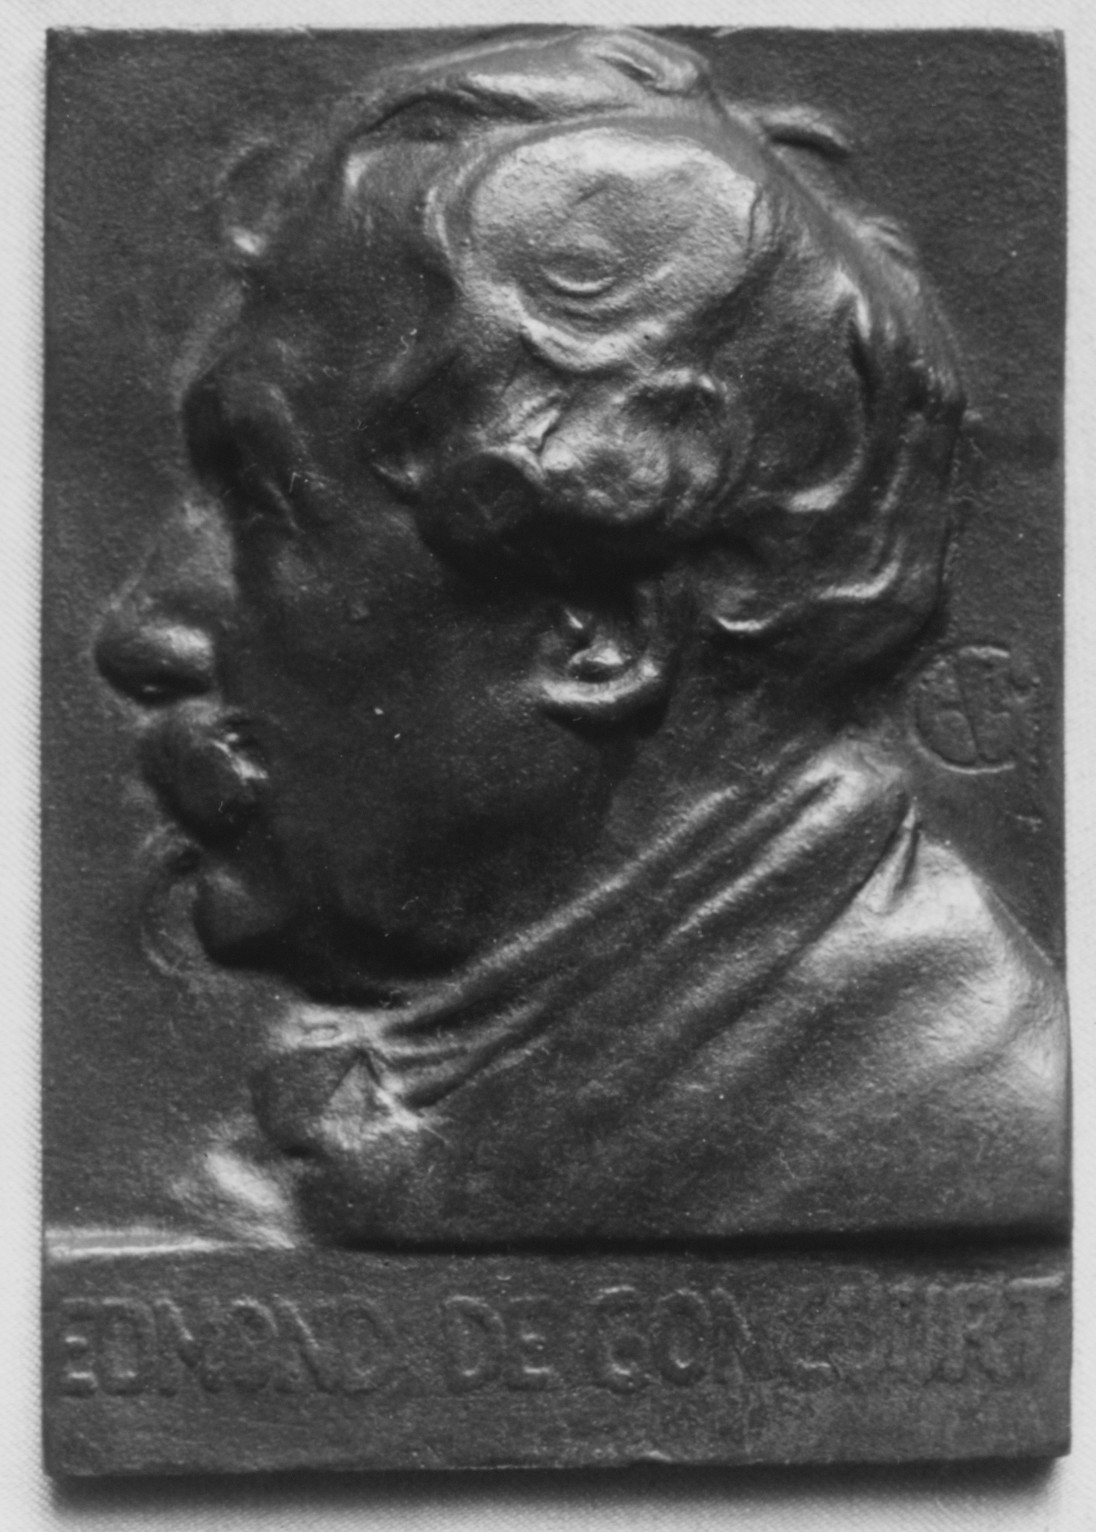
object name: plaquette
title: Portrait of Edmond de Goncourt (1822–1896), novelist and man of letters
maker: alexandre-louis-marie charpentier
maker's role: artist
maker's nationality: french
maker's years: 1856-1909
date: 1867-1900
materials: bronze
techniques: casting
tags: men,profiles